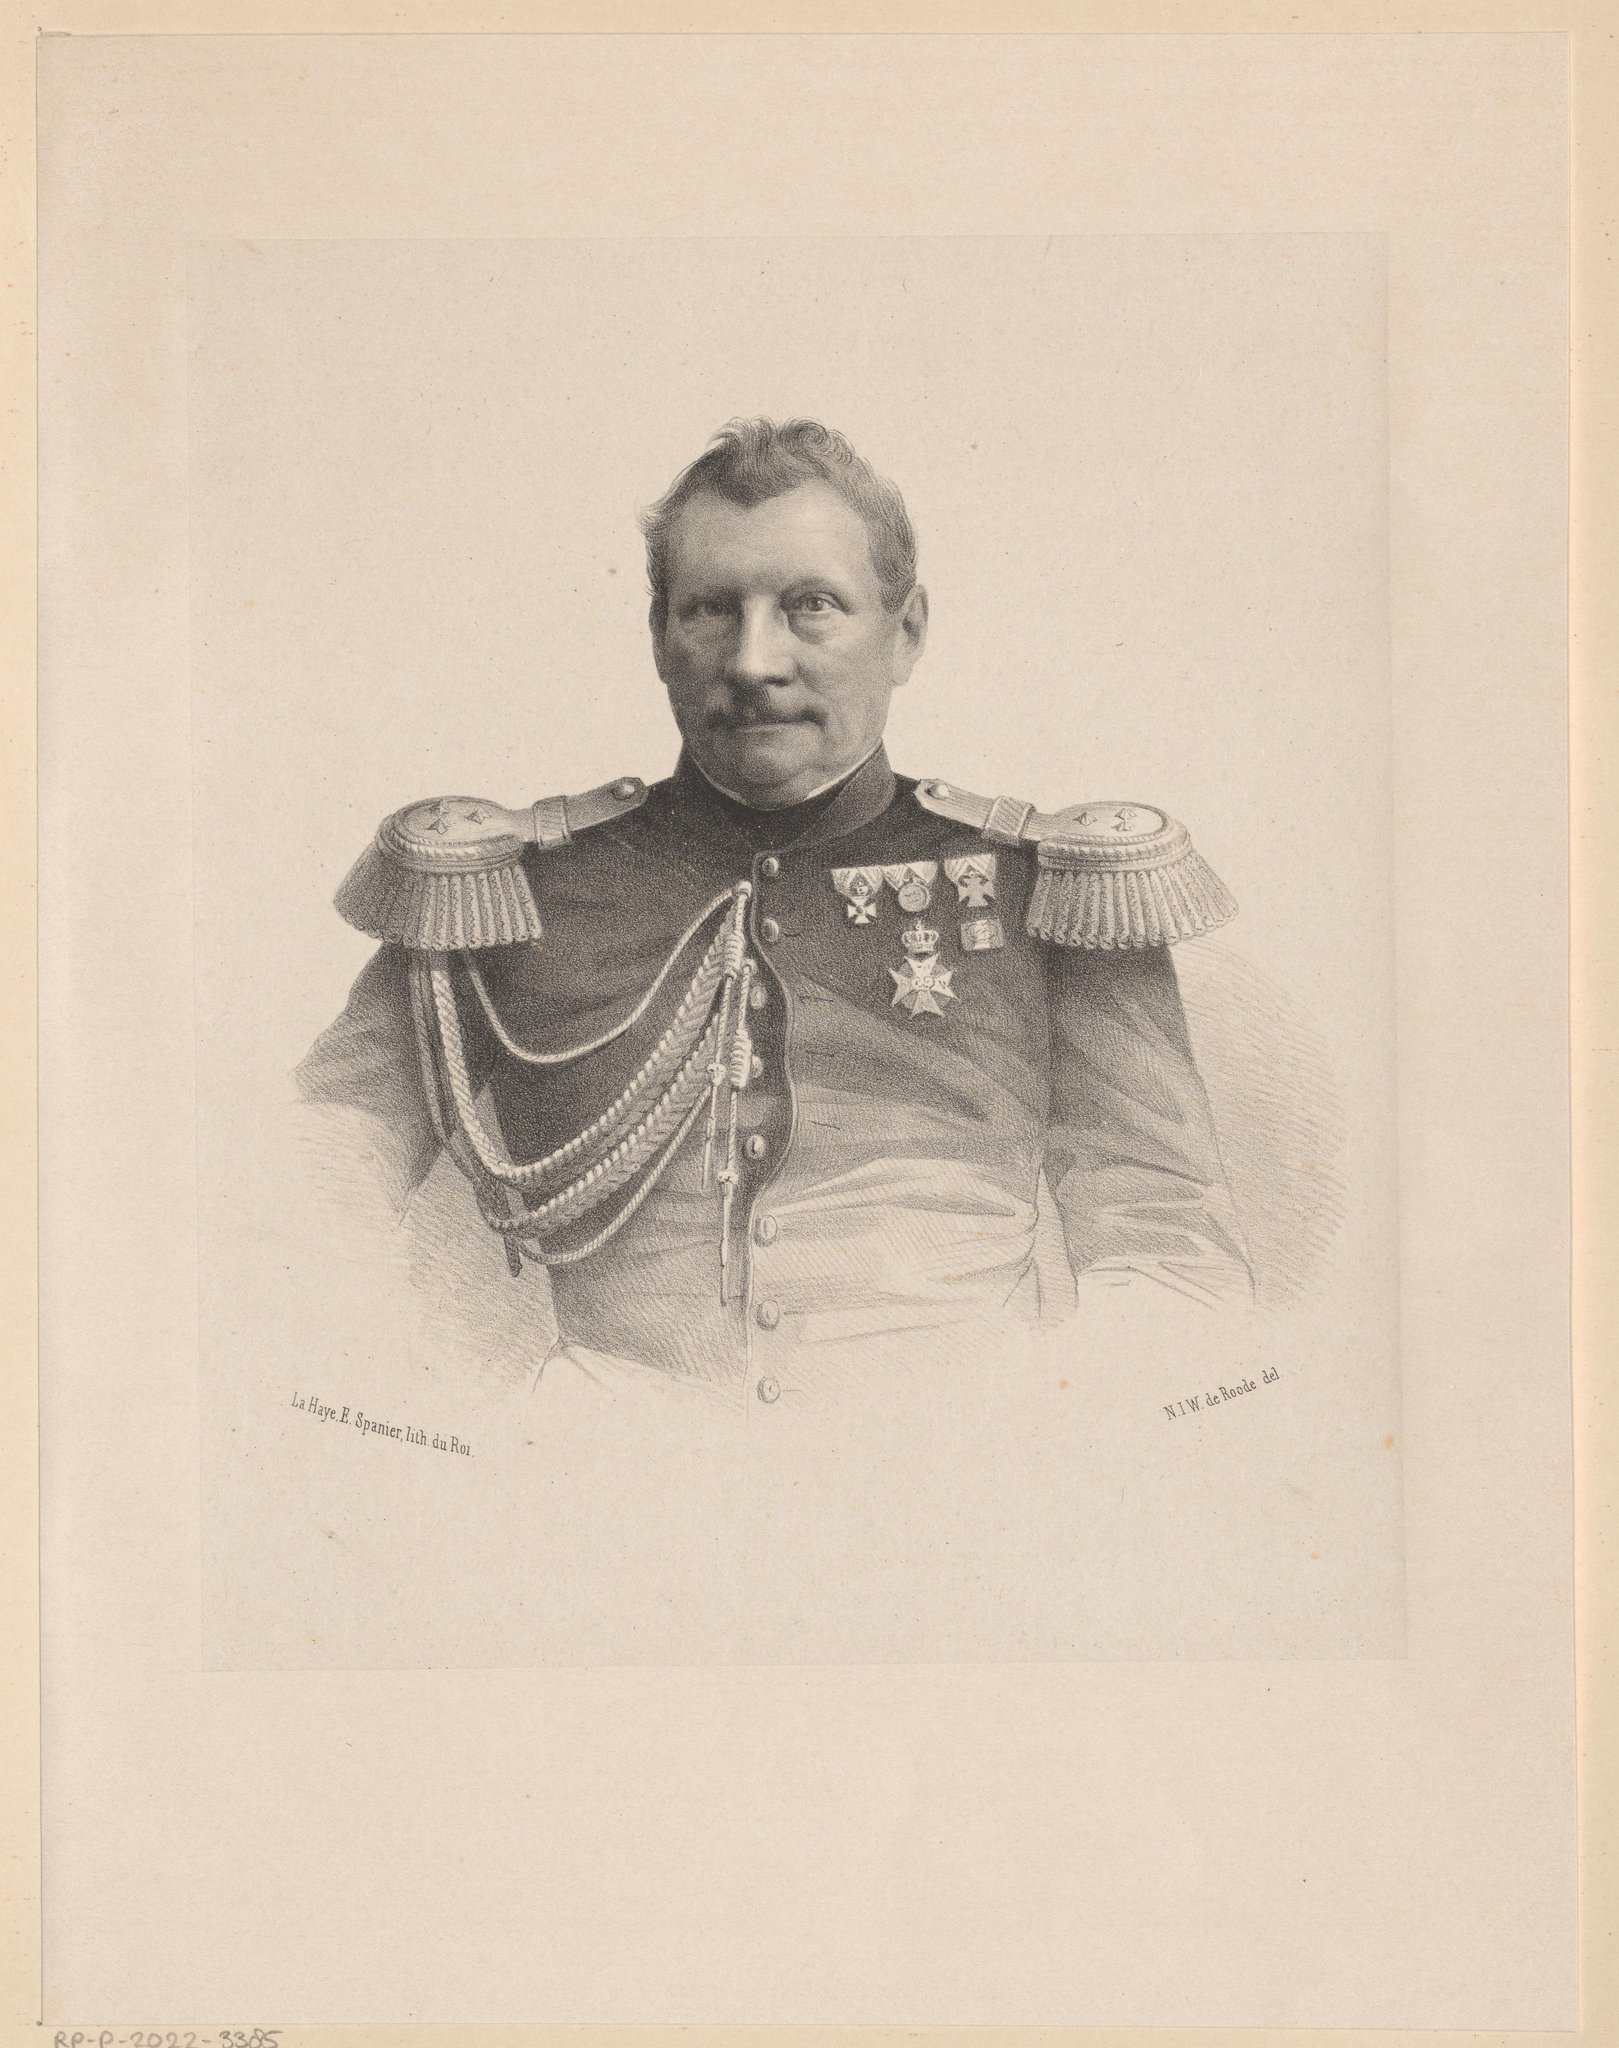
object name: print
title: Portret van Jan van Swieten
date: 1874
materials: paper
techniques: lithograph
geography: the hague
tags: commander-in-chief, general, marshal, historical persons, medals and other marks of military honour